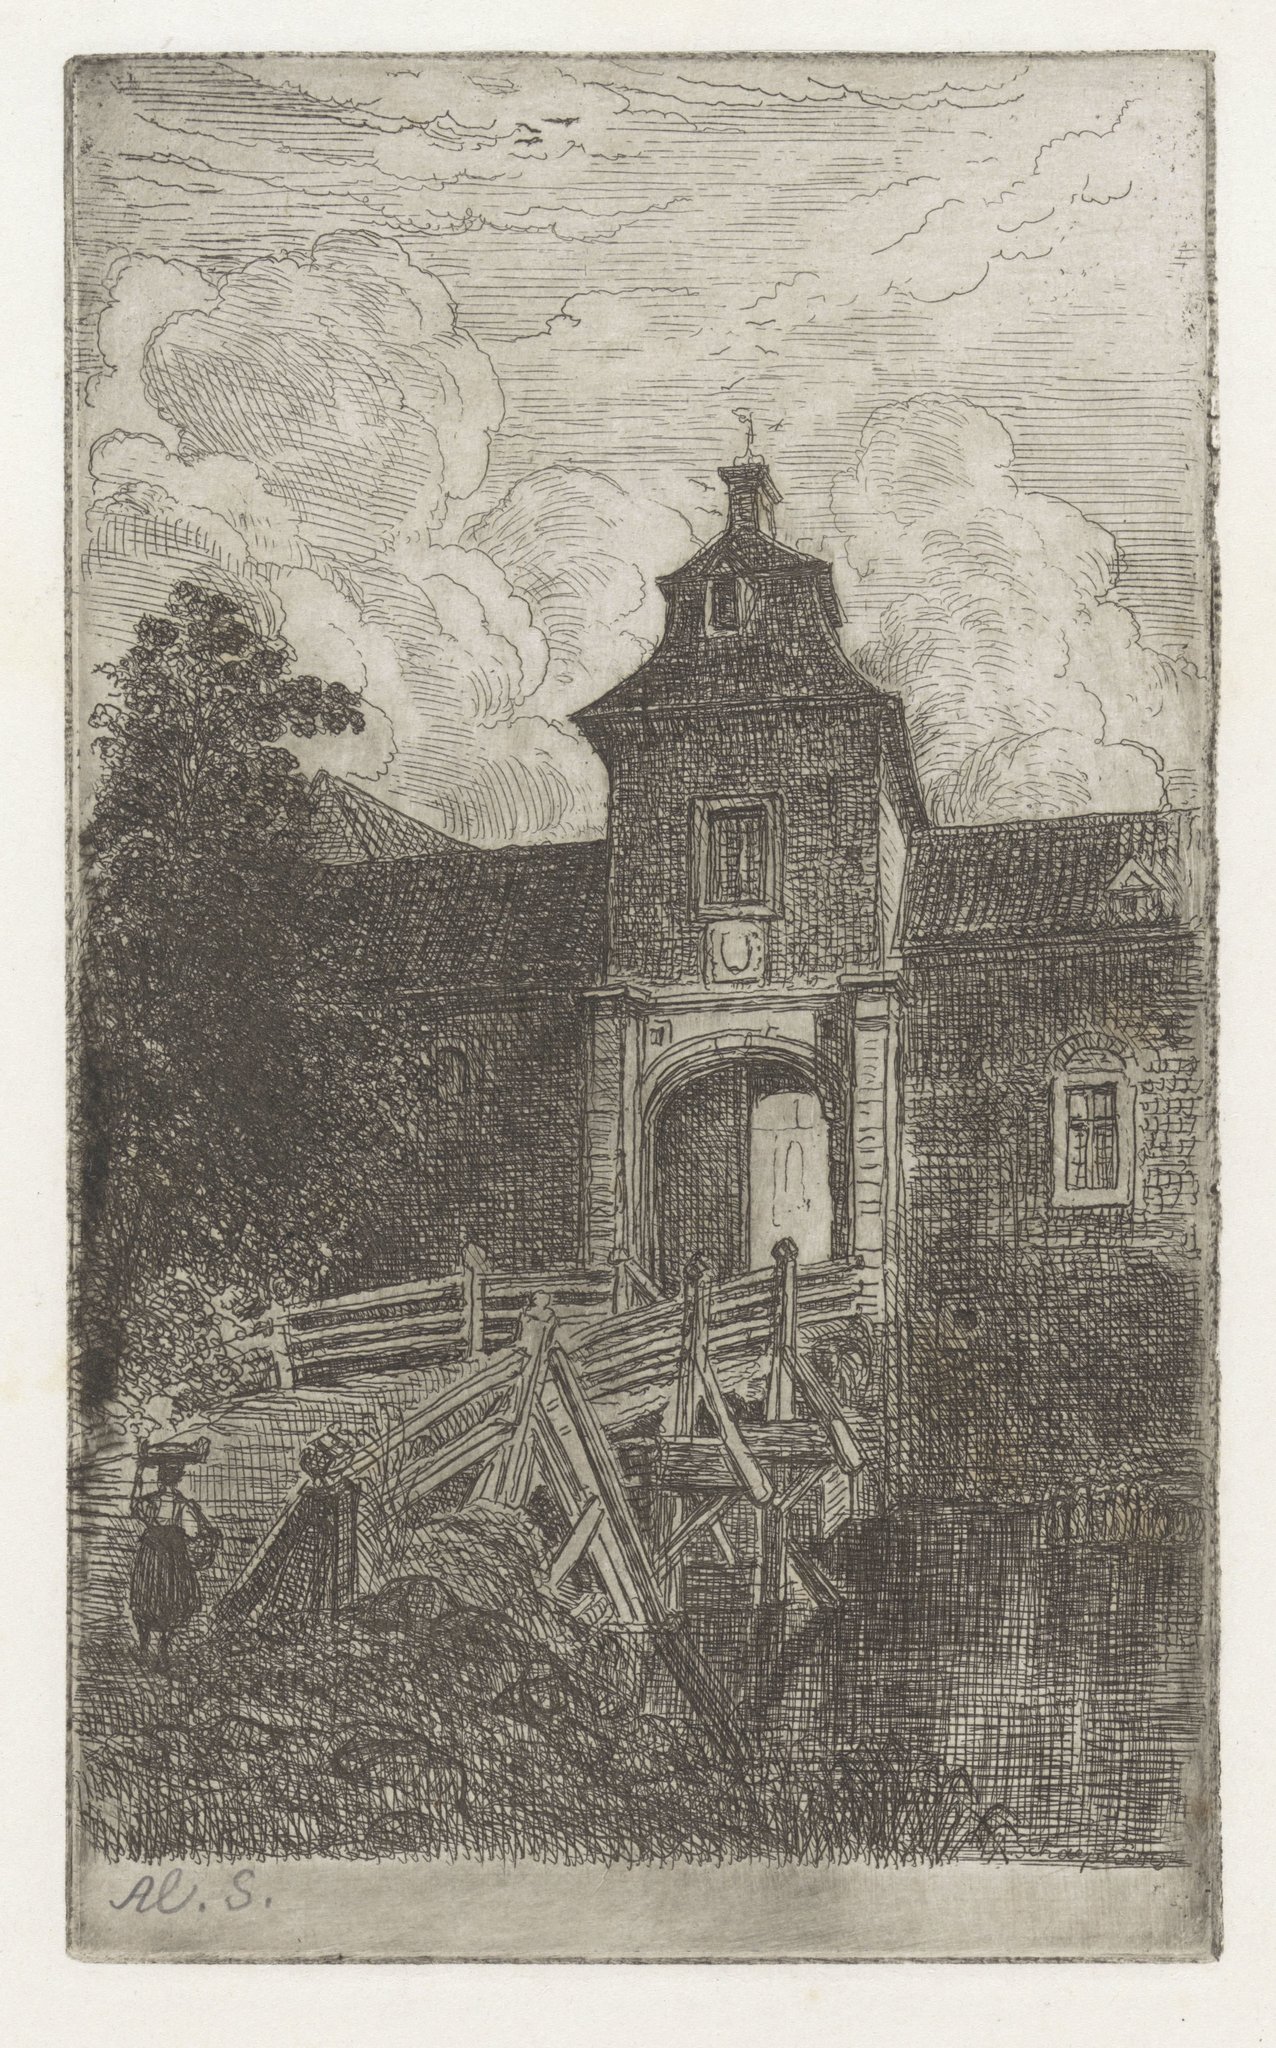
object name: print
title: Houten brug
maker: alexander schaepkens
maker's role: draughtsman, print maker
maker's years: 1815-1899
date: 1830-1899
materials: paper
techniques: etching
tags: gate, entrance, bridge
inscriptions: collector's mark: Lugt 1485, collector's mark: Lugt 2228